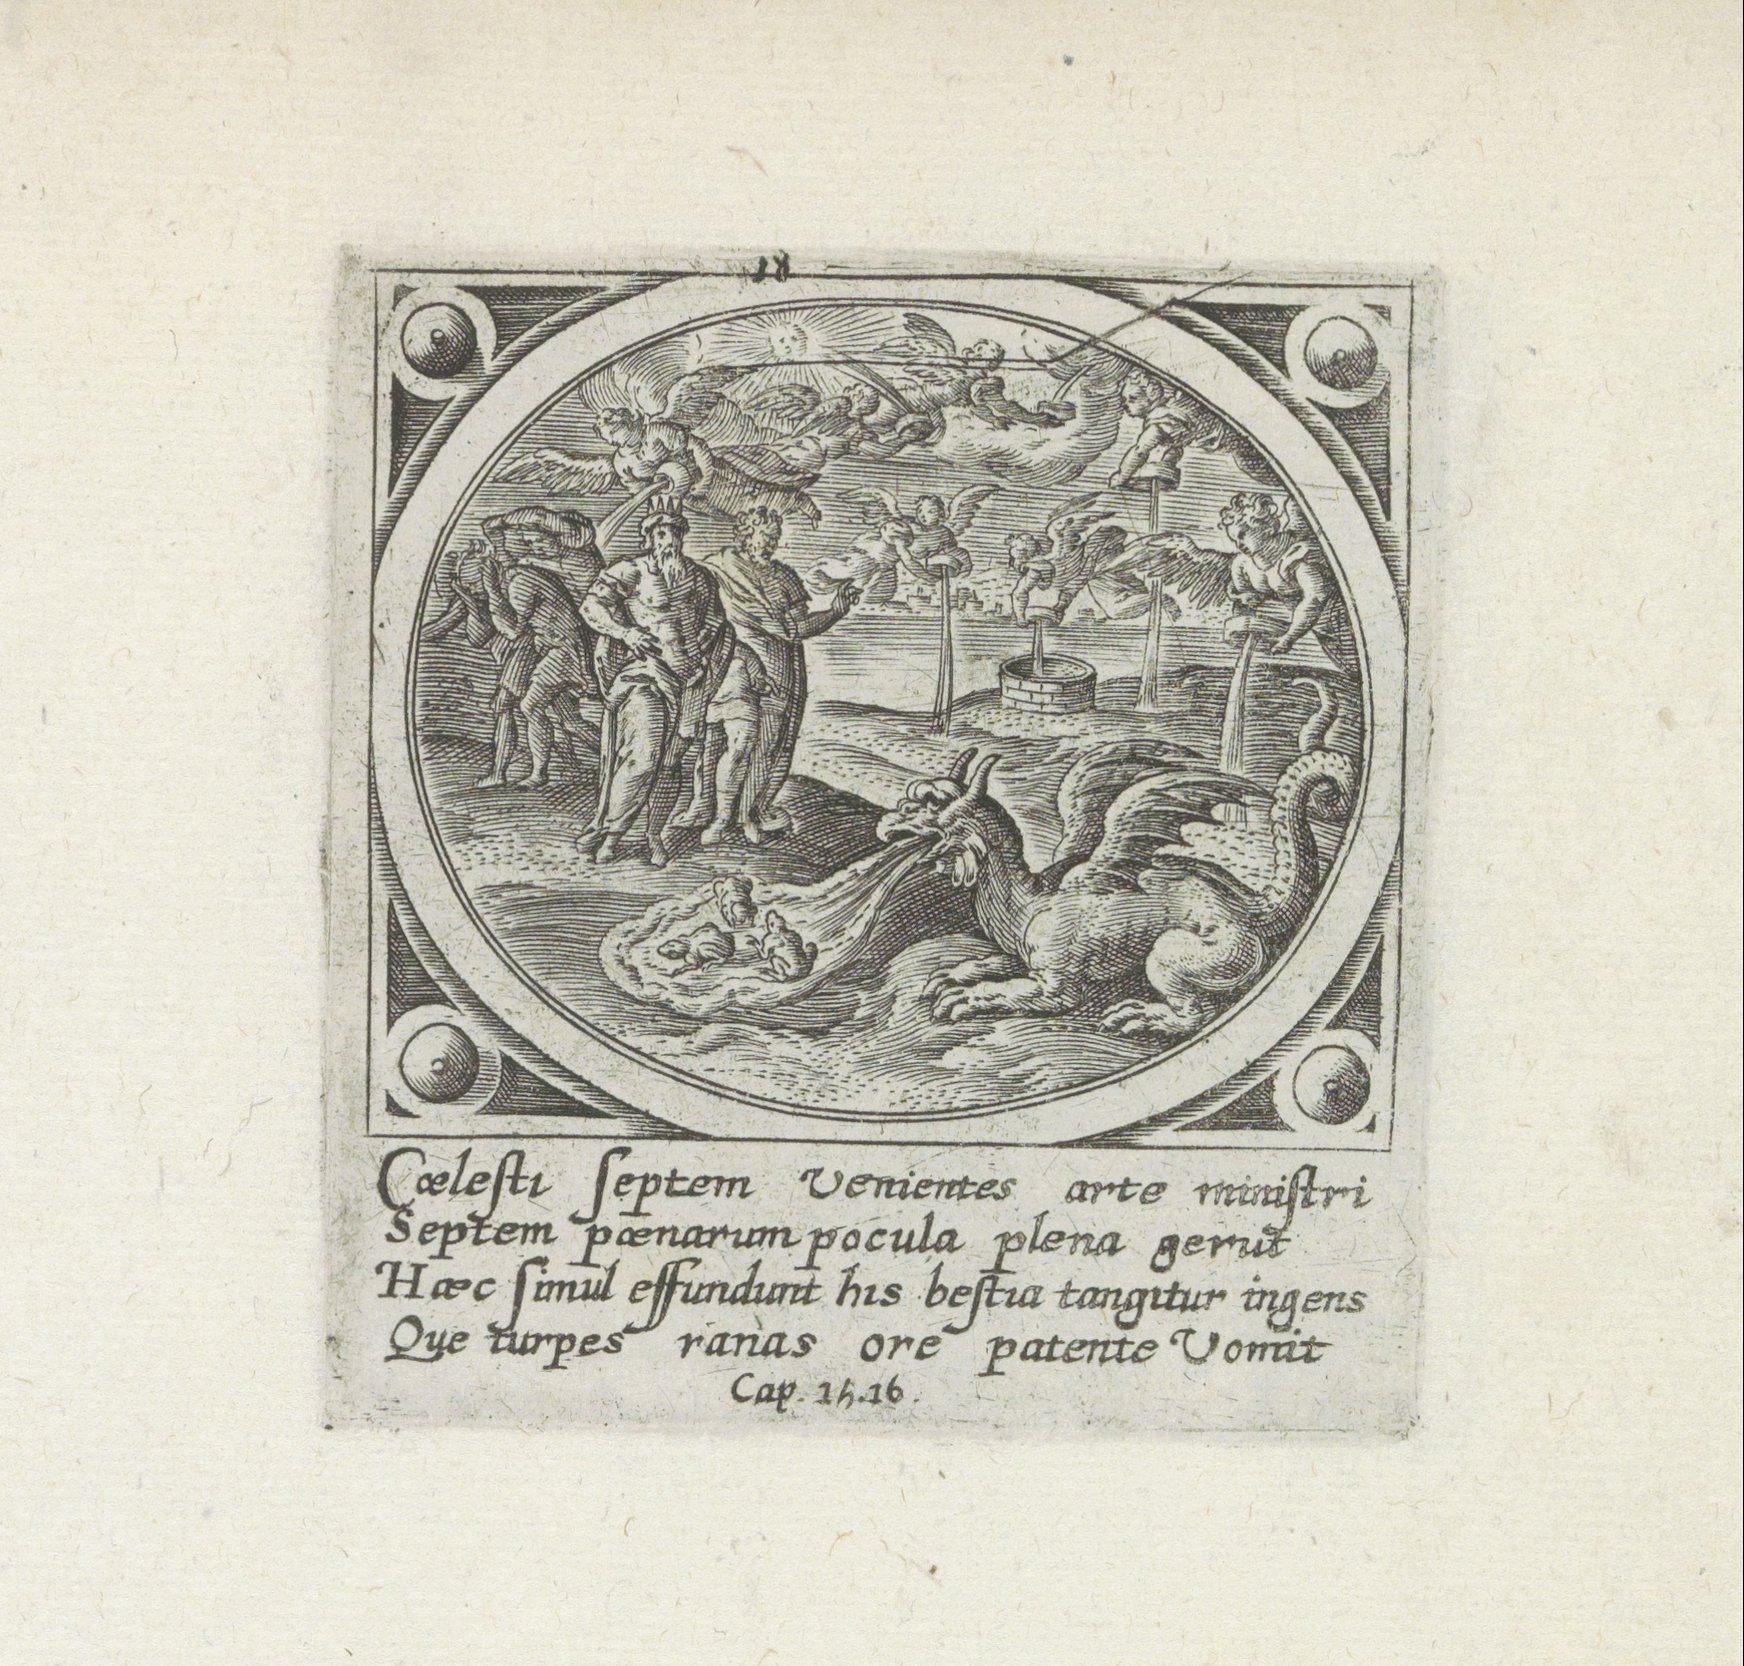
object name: print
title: Zeven plagen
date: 1585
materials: paper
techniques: engraving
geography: antwerp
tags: the seven angels with the seven vials, bringing disasters and destruction upon the earth and mankind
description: Engelen gieten schalen leeg die plagen veroorzaken. Op de voorgrond de zesde plaag: een draak die kikkers braakt. Onder de voorstelling een verwijzing in het Latijn naar de Bijbeltekst in Op. 15-16. Deze prent maakt deel uit van een album.